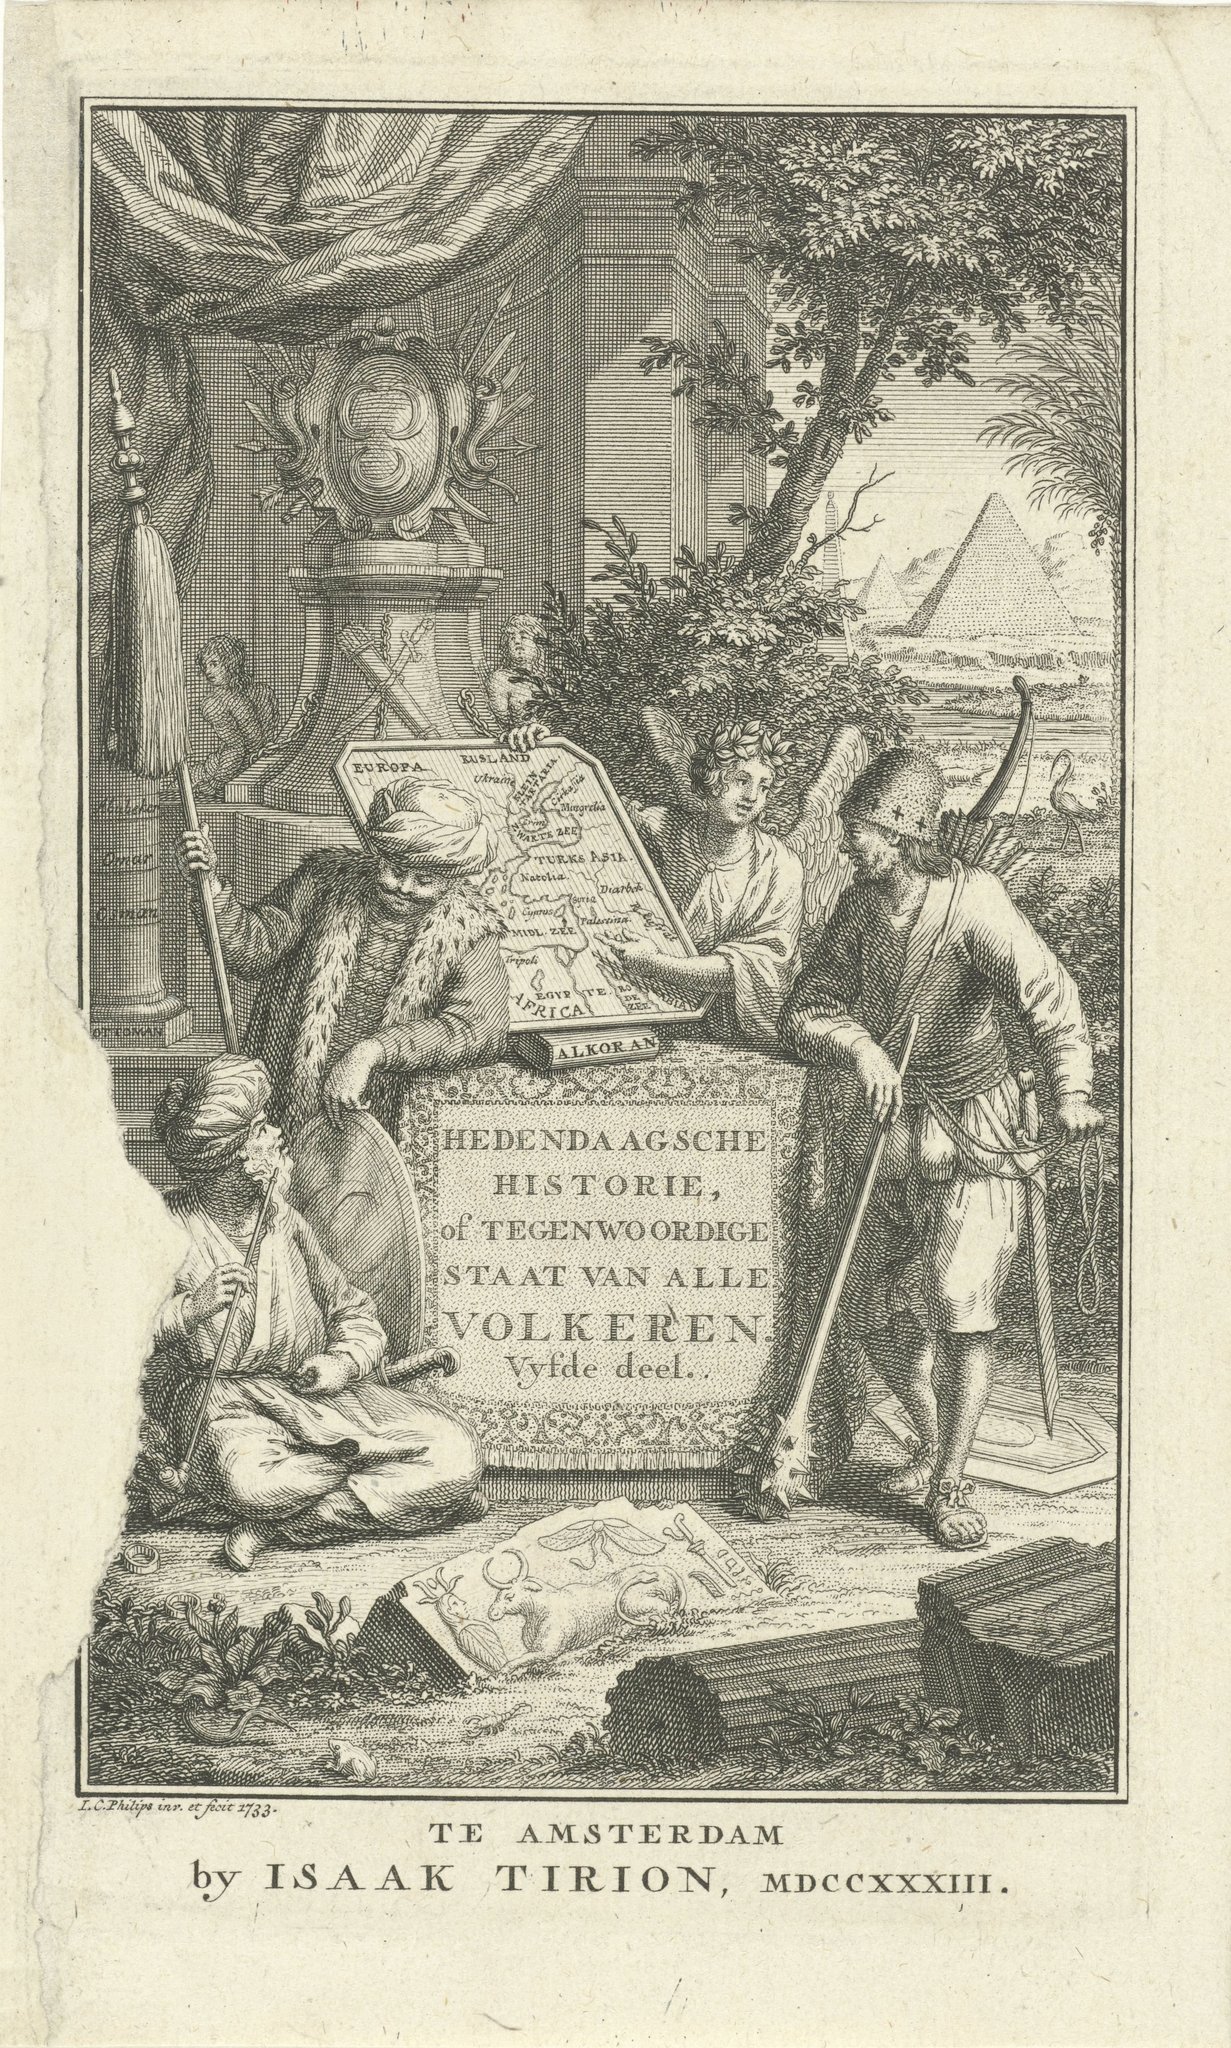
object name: titelblad, titelpagina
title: Titelpagina voor: Thomas Salmon, Hedendaagsche historie, of Tegenwoordige staat van alle volkeren, 1733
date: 1733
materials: paper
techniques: engraving, etching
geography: amsterdam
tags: coat of arms (as symbol of the state, etc.), asiatic races and peoples: turks, maps, atlases, pyramid (historical grave form), 'historia'; 'historia' (ripa)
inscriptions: collector's mark: Lugt 2228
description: Architecturale nis waarin het wapenschild van het Turkse Rijk op een sokkel. Geschiedenis toont een Turk de landkaart van het Turkse Rijk. Op de voorgrond antieke oudheden. Op een piëdestal de titel in het Nederlands. Op de achtergrond een landschap met piramides.